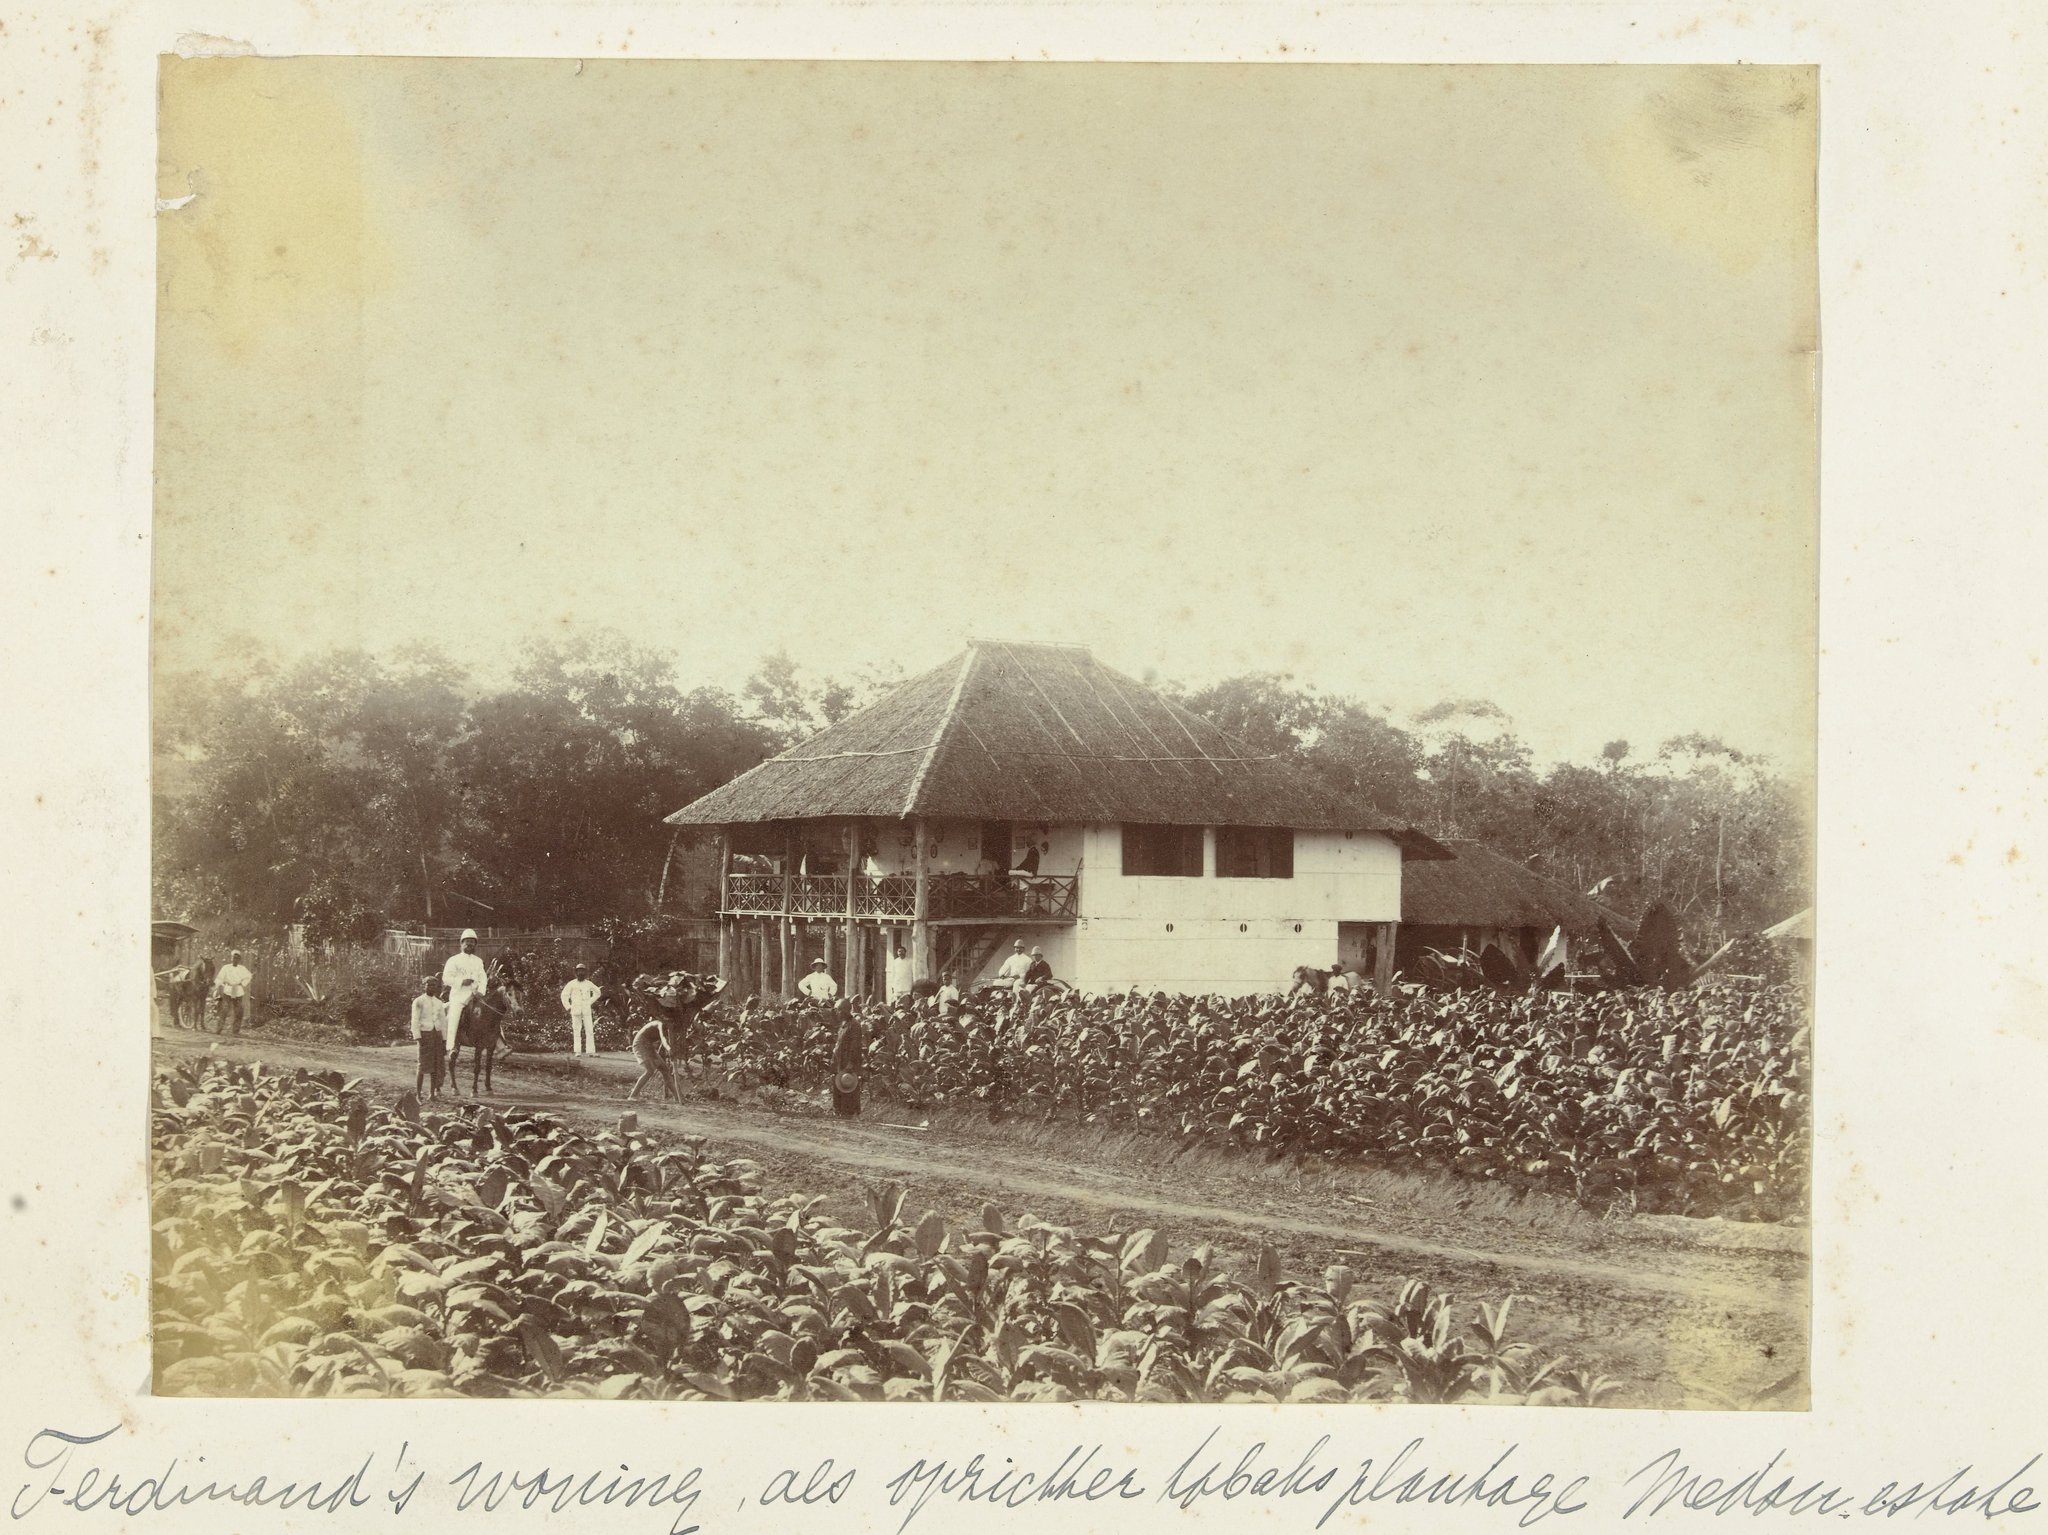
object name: photograph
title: Woning met daarvoor poserend personeel en opzichter tussen de tabaksvelden van tabaksplantage Medan Estate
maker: Anonymous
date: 1890-1910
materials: cardboard, paper, photographic support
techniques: gelatin silver print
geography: netherlands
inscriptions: caption: ‘Ferdinand's woning als opzichter tabaksplantage Medan estate.’